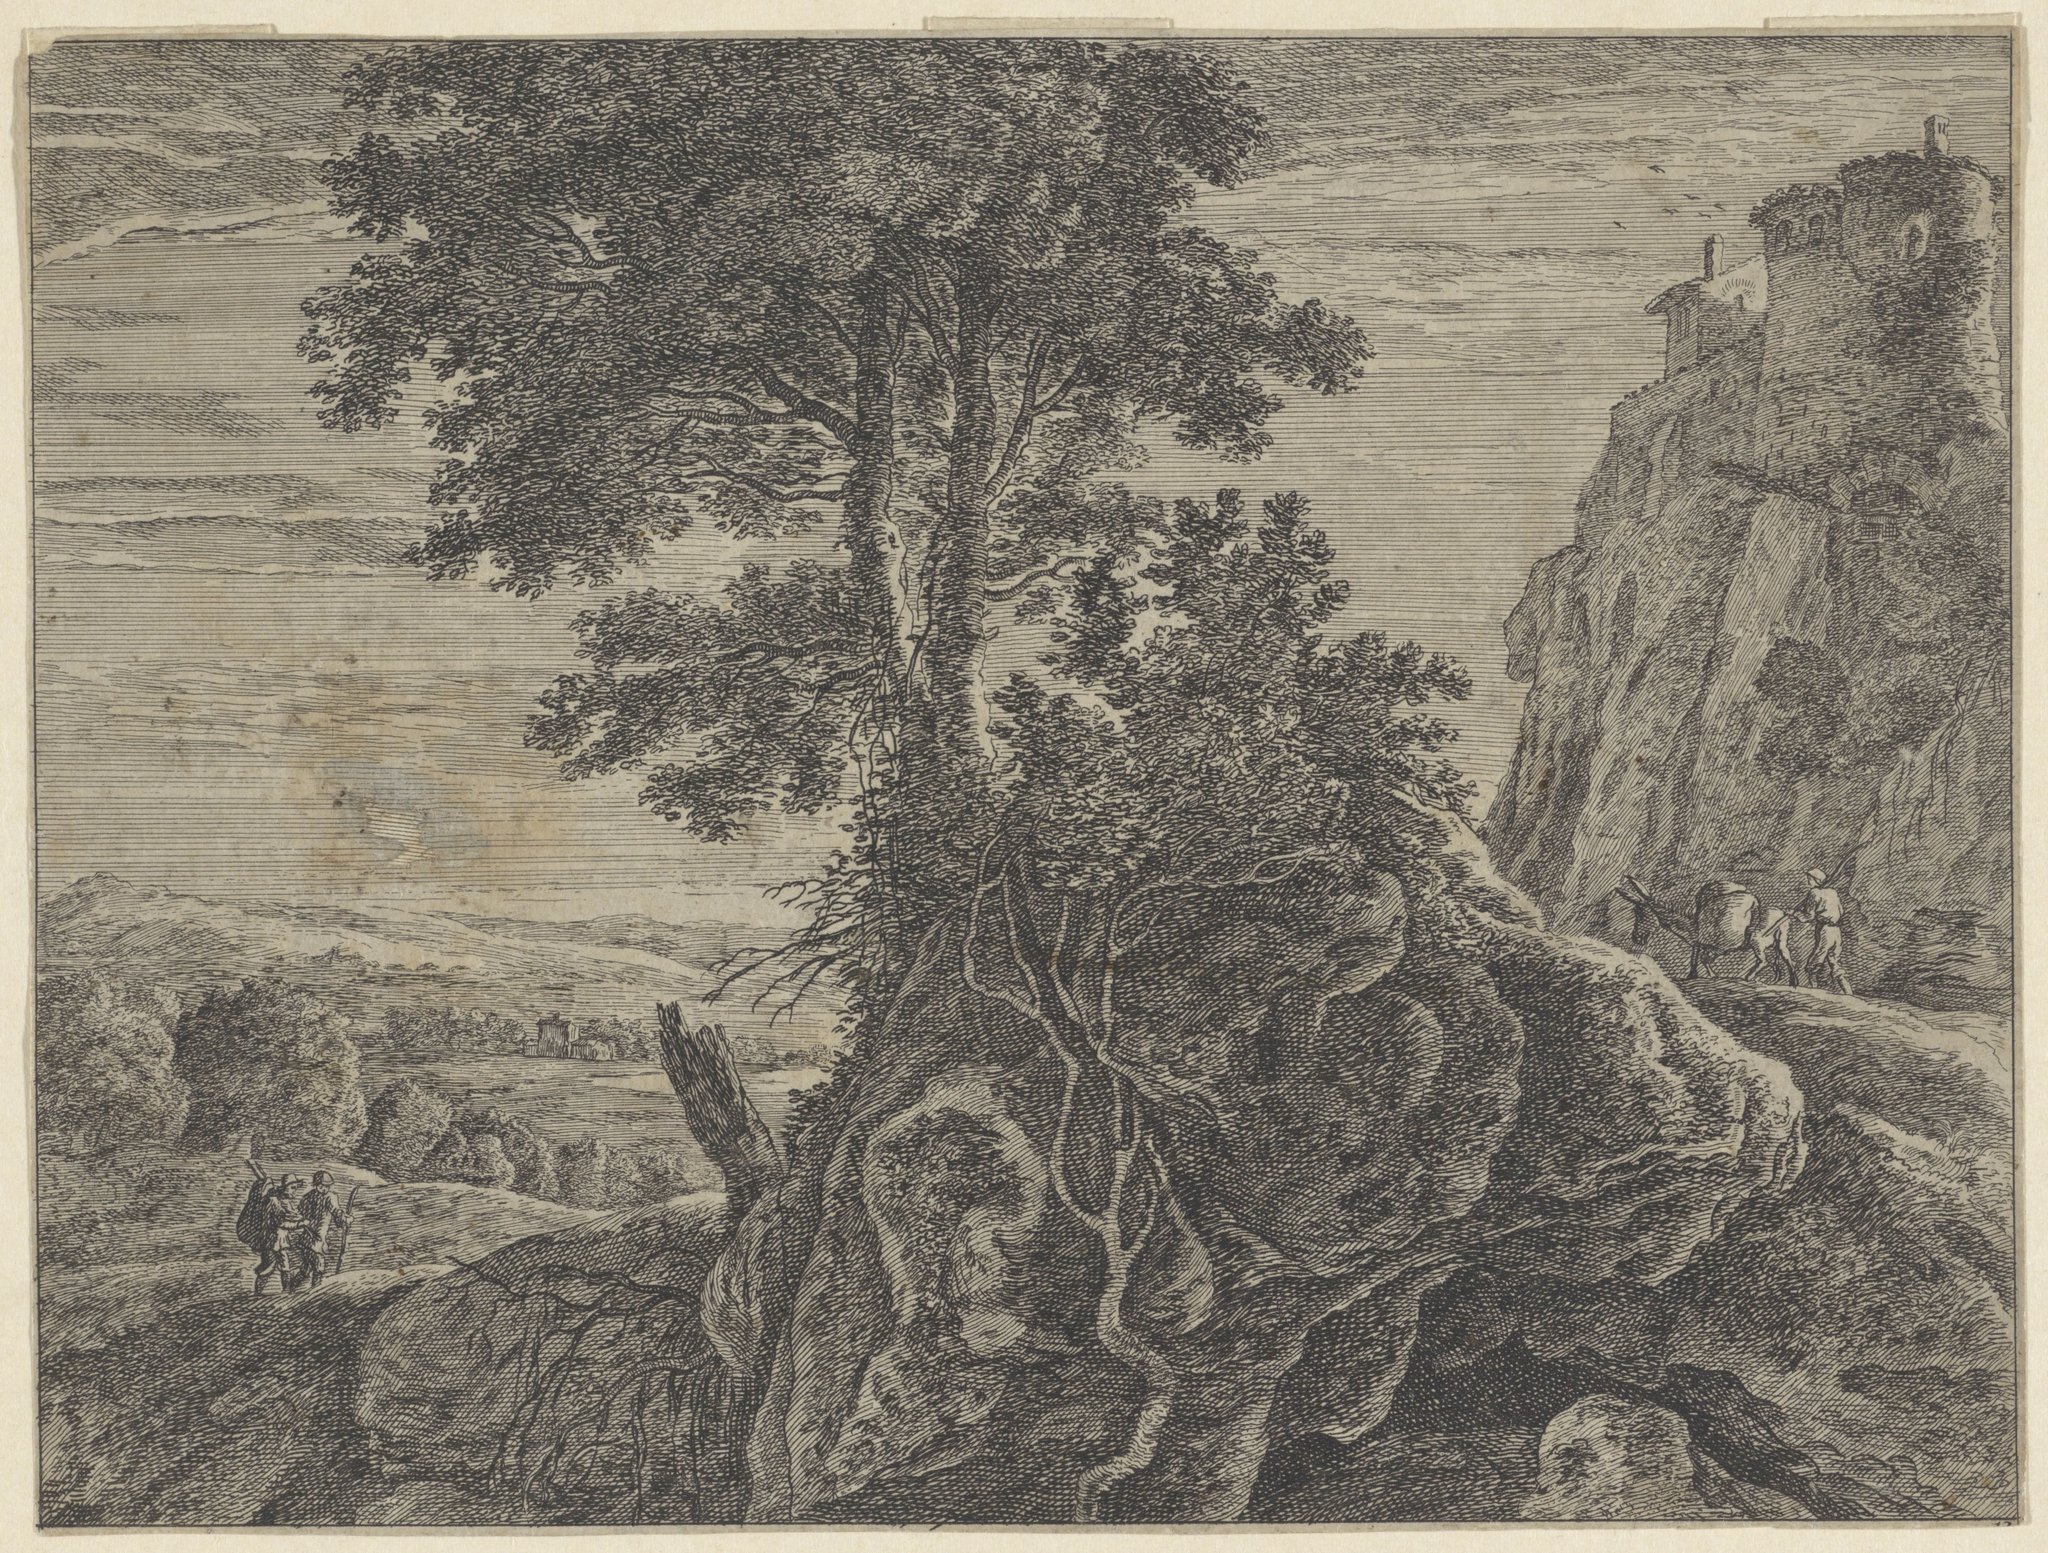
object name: print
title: Landschap met een gebouw op een rots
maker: Anonymous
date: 1643-1705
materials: paper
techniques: etching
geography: paris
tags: riding a horse, ass, or mule; rider, horseman, landscapes, ass, donkey, river, rural housing, e.g. country-house, villa, cottage, (high) hill, brook, 'en route', traveller under way, rocks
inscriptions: collector's mark: Lugt 2228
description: In de buurt van een groep bomen lopen enkele wandelaars over een pad, van wie een een ezel drijft. Op een hoge rots ligt een versterkt gebouw.